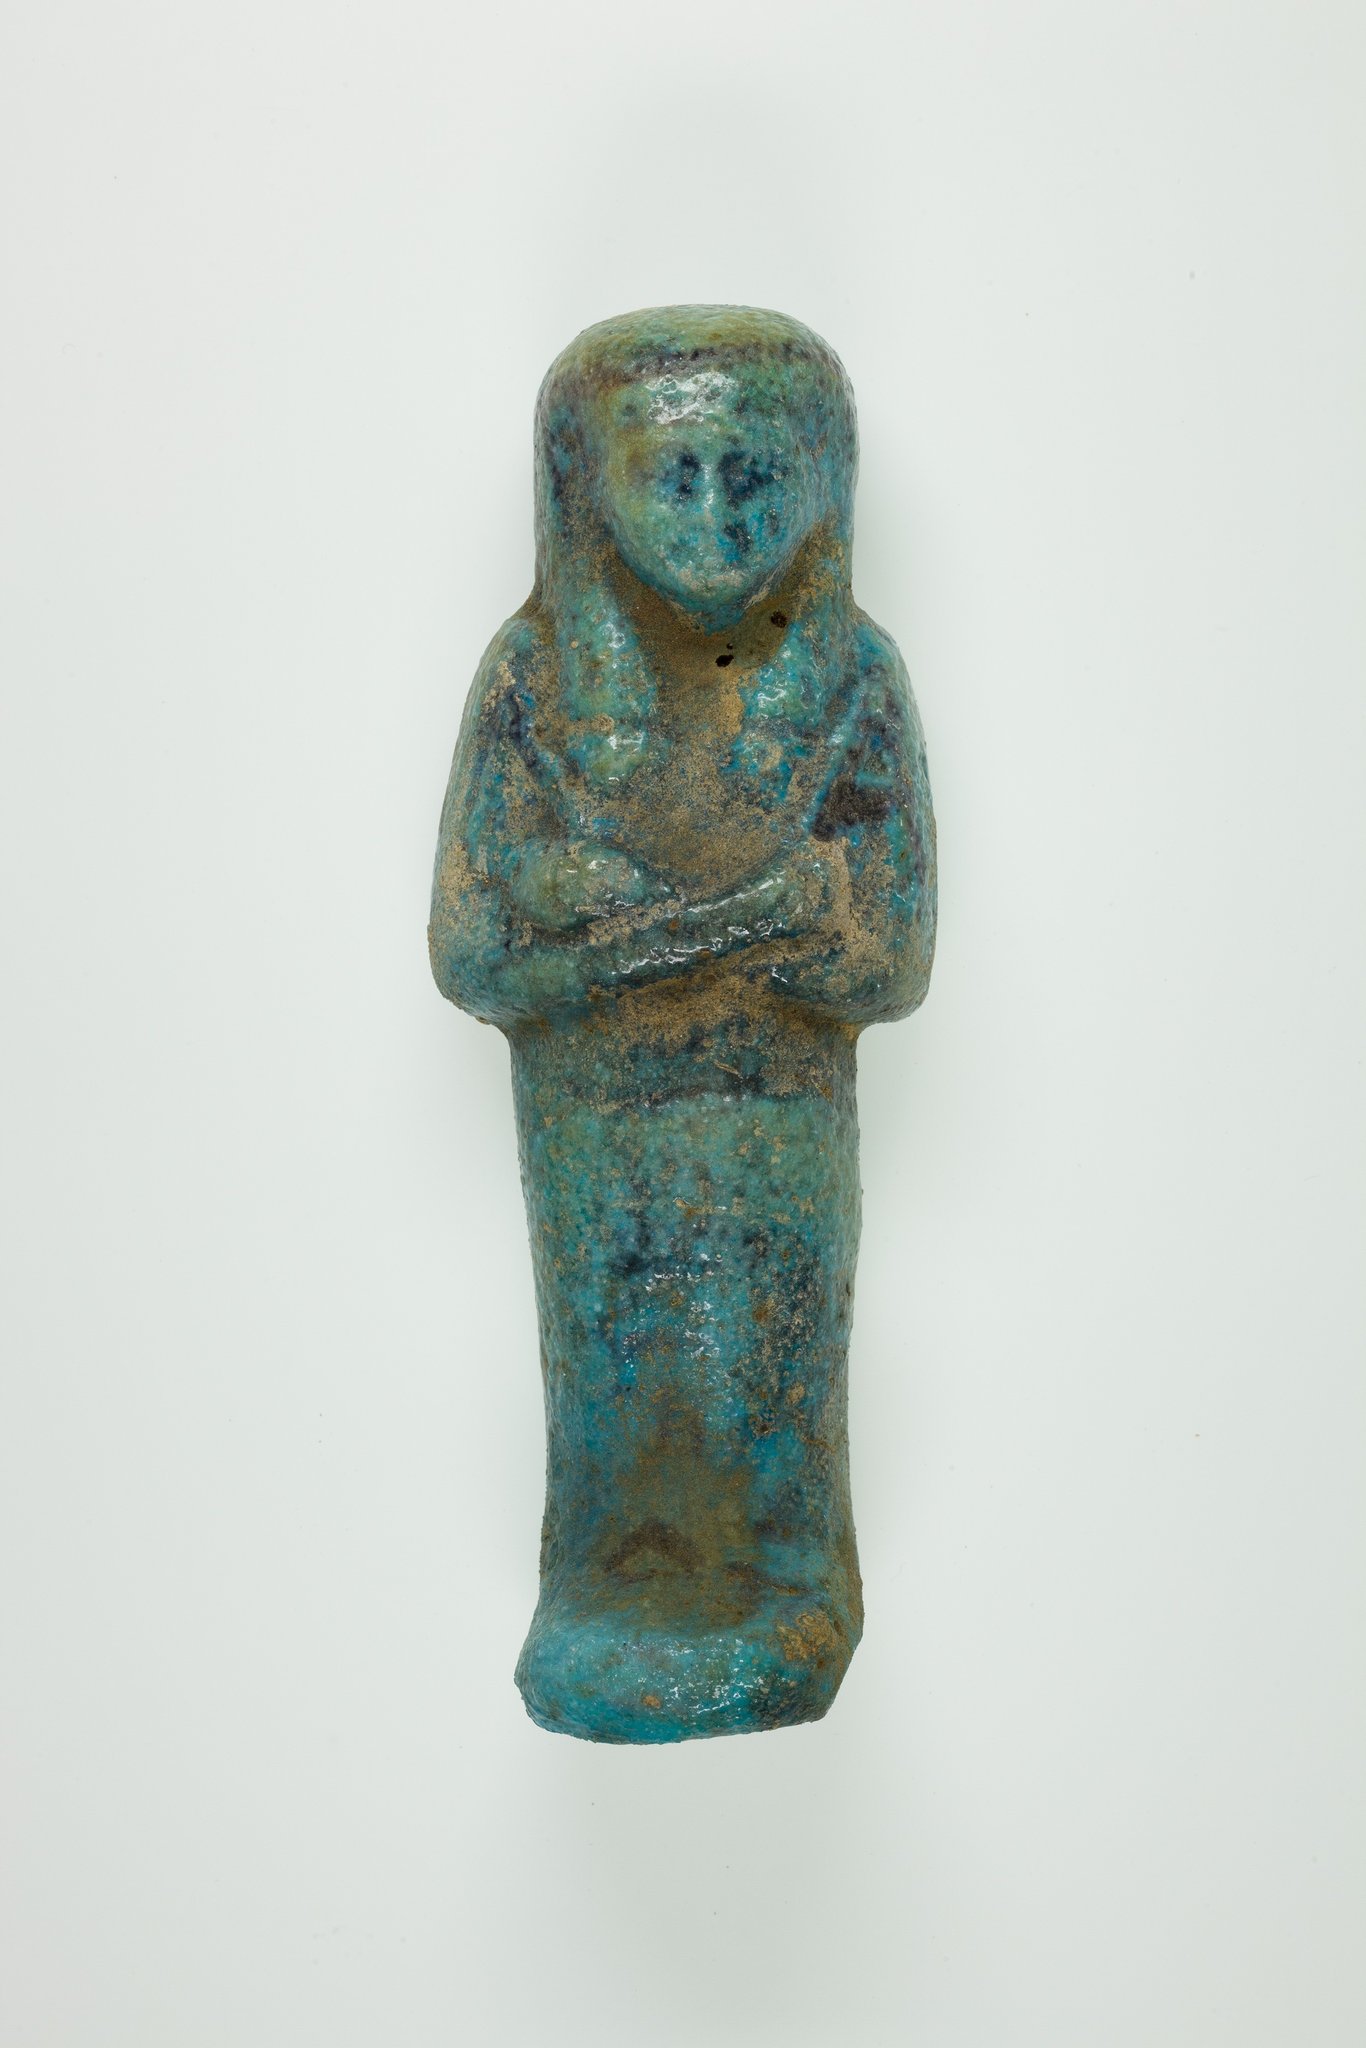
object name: worker shabti, henettawy c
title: Worker Shabti of Henettawy (C), Daughter of Isetemkheb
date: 990-970 BCE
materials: faience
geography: egypt